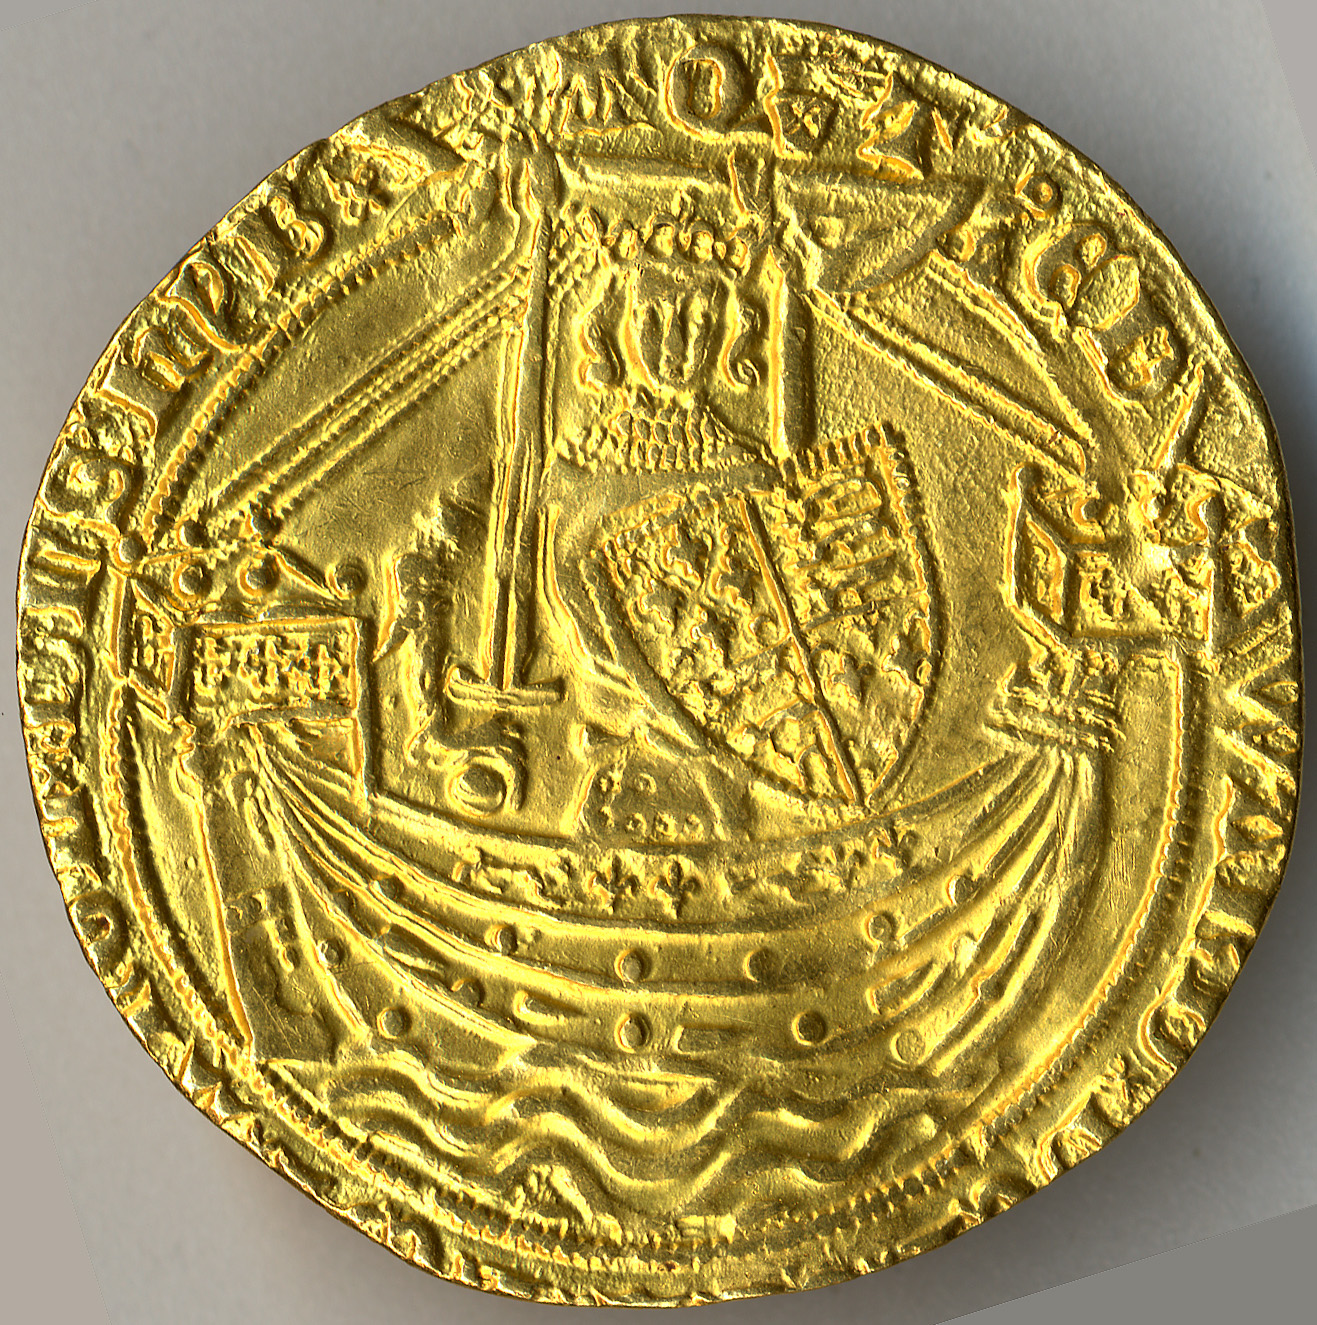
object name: coin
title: Noble of Edward III (r. 1327–77)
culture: british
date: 1361-1369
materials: gold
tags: coat of arms